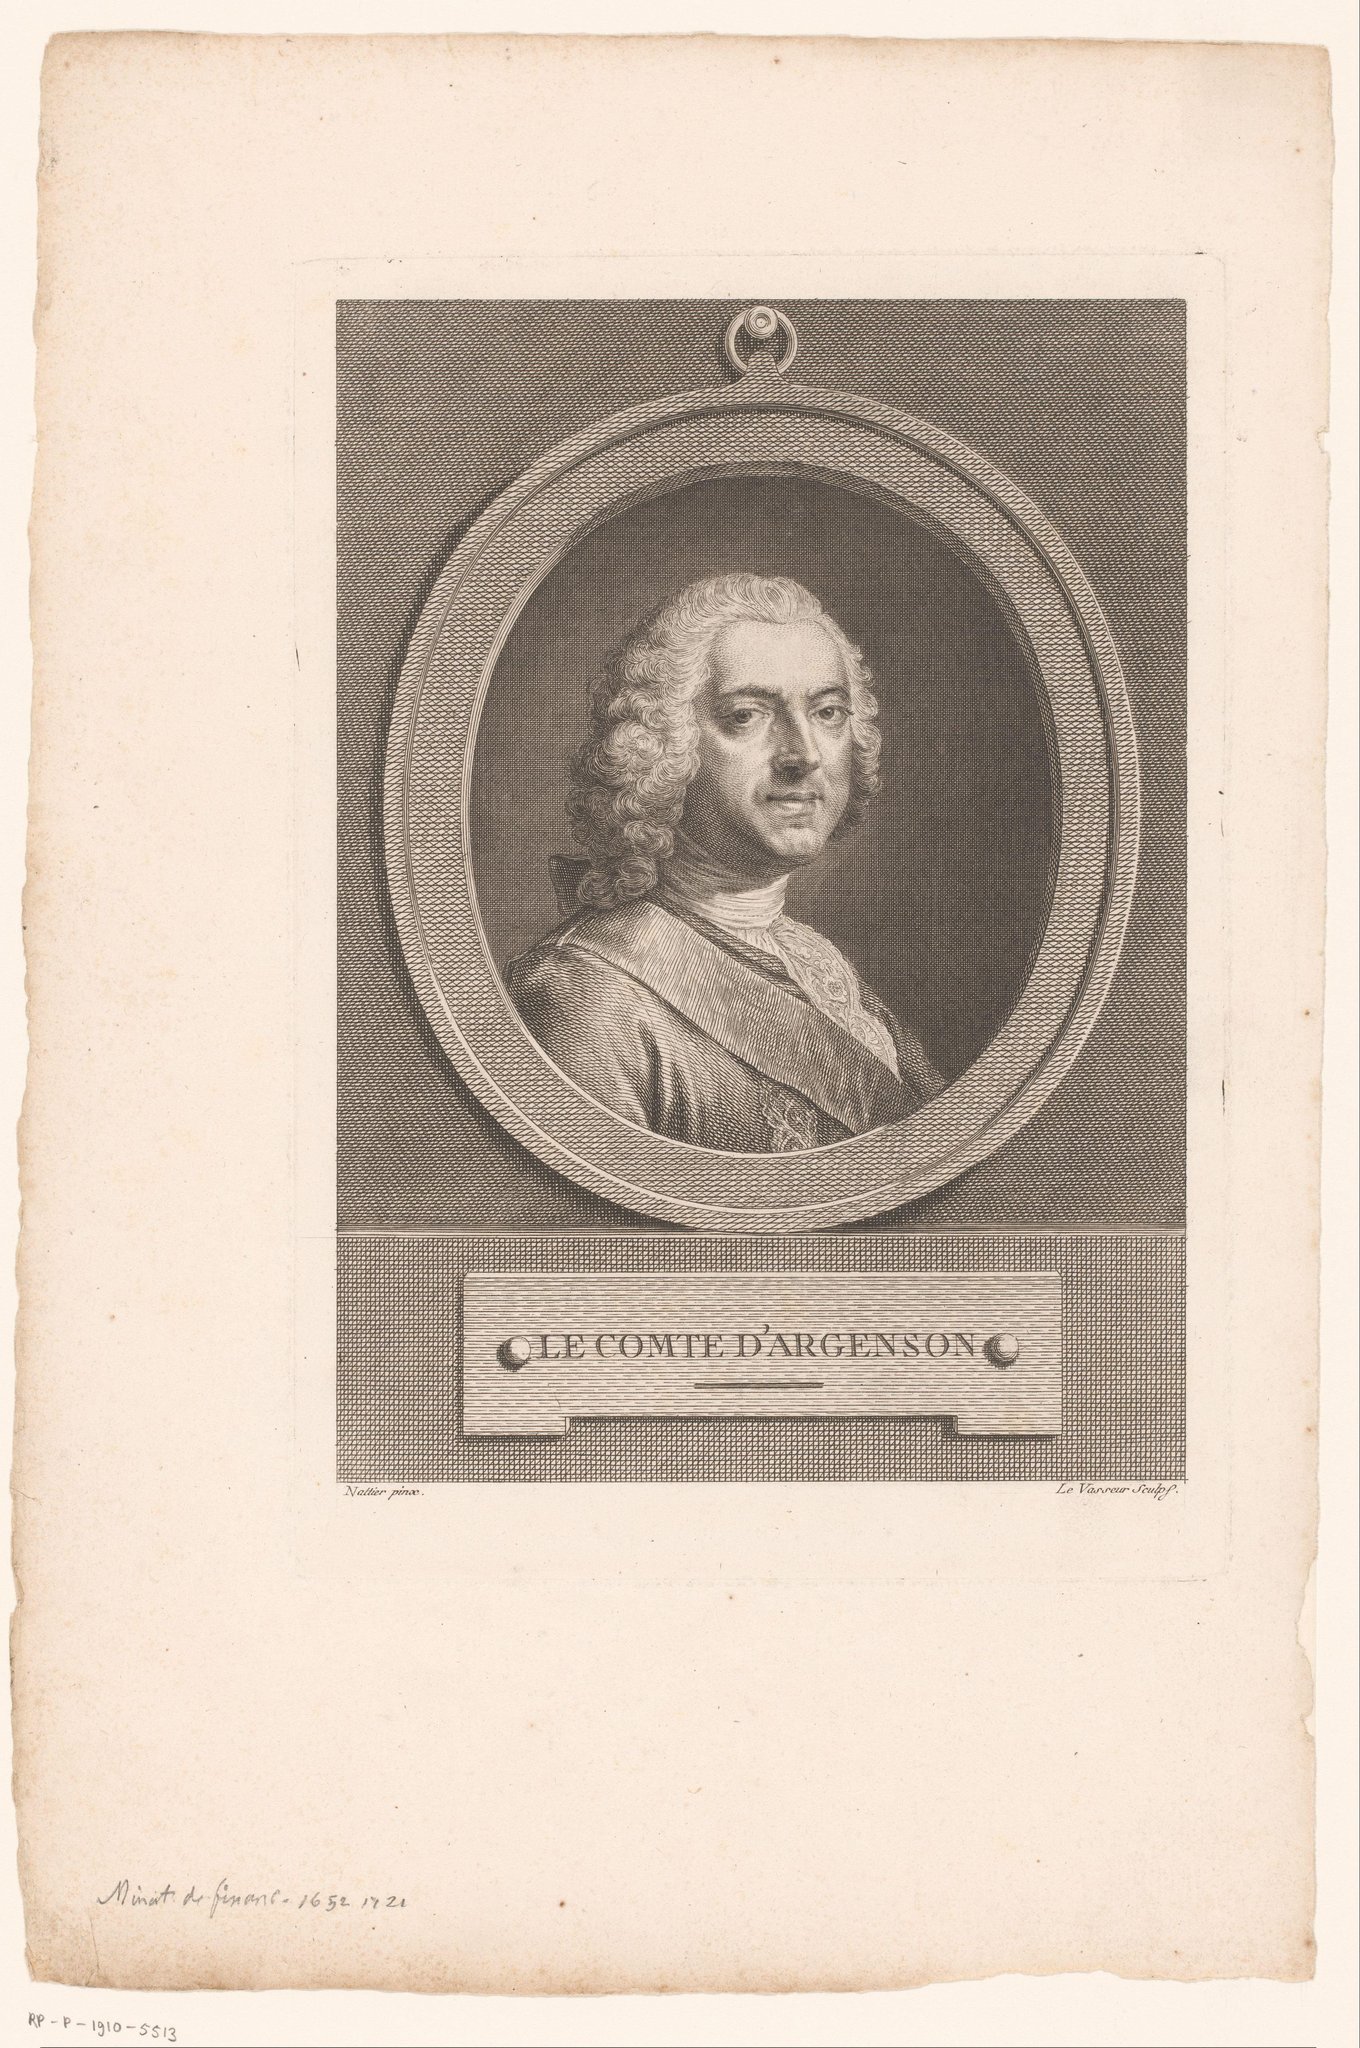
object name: print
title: Le Comte d'Argenson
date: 1744-1816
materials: paper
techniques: engraving, etching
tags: marc-pierre de voyer de paulmy (marquis d'argenson), ornament ~ medallion, historical persons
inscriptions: collector's mark: Lugt 2228